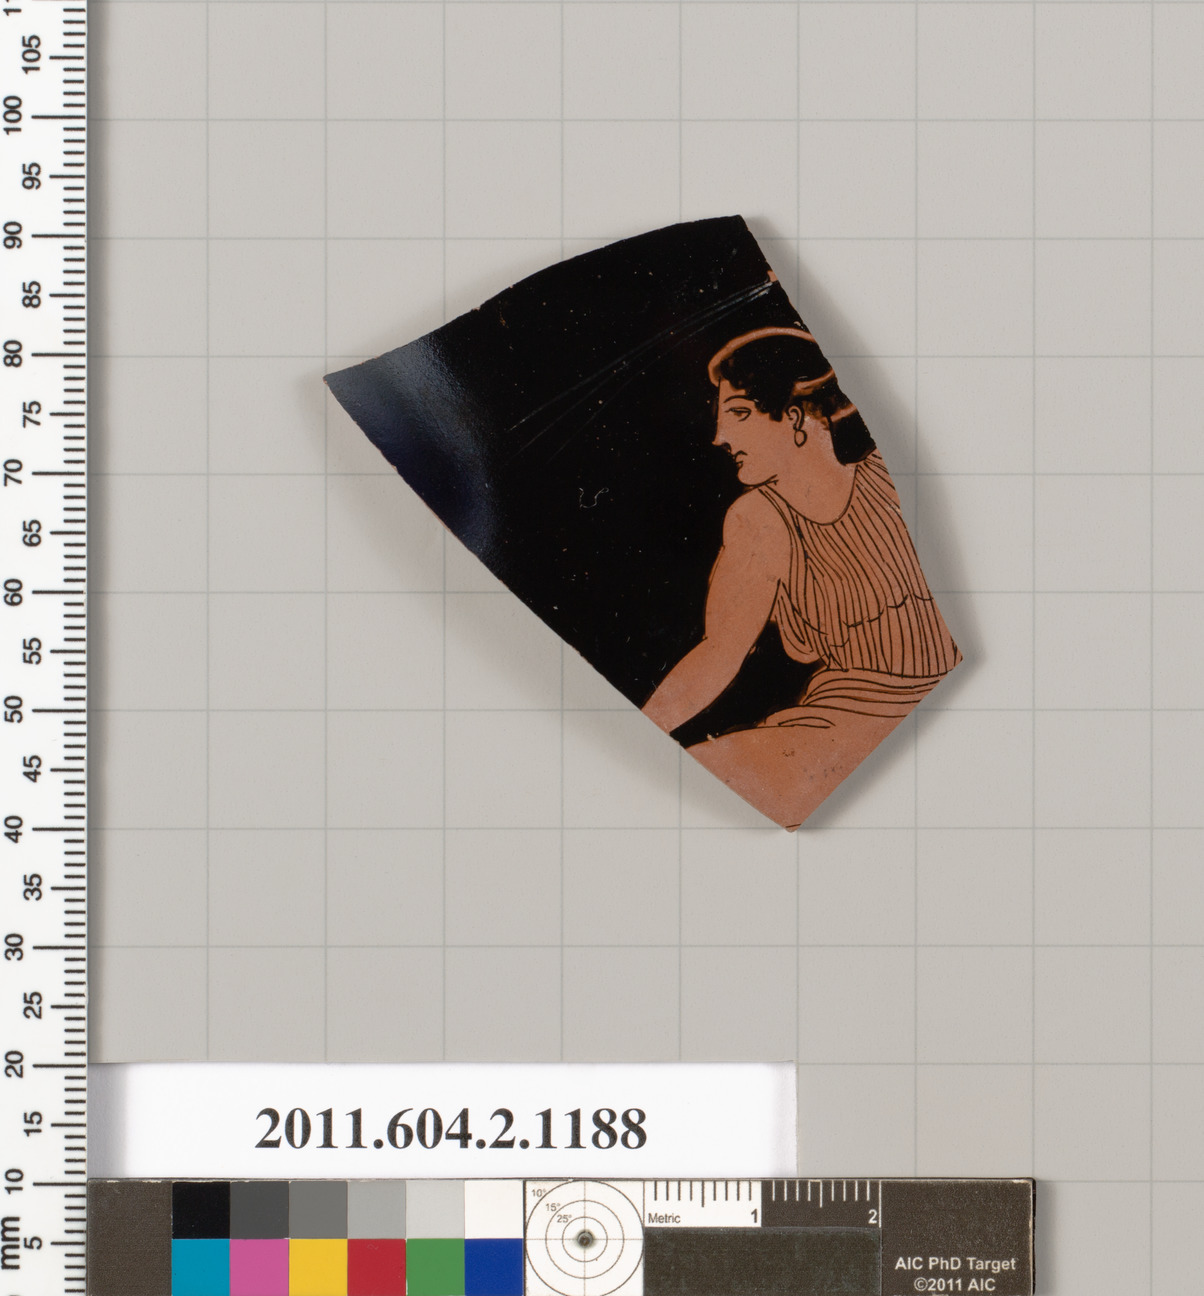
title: Terracotta fragment from an undetermined shape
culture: greek, attic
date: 475-451 BCE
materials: terracotta